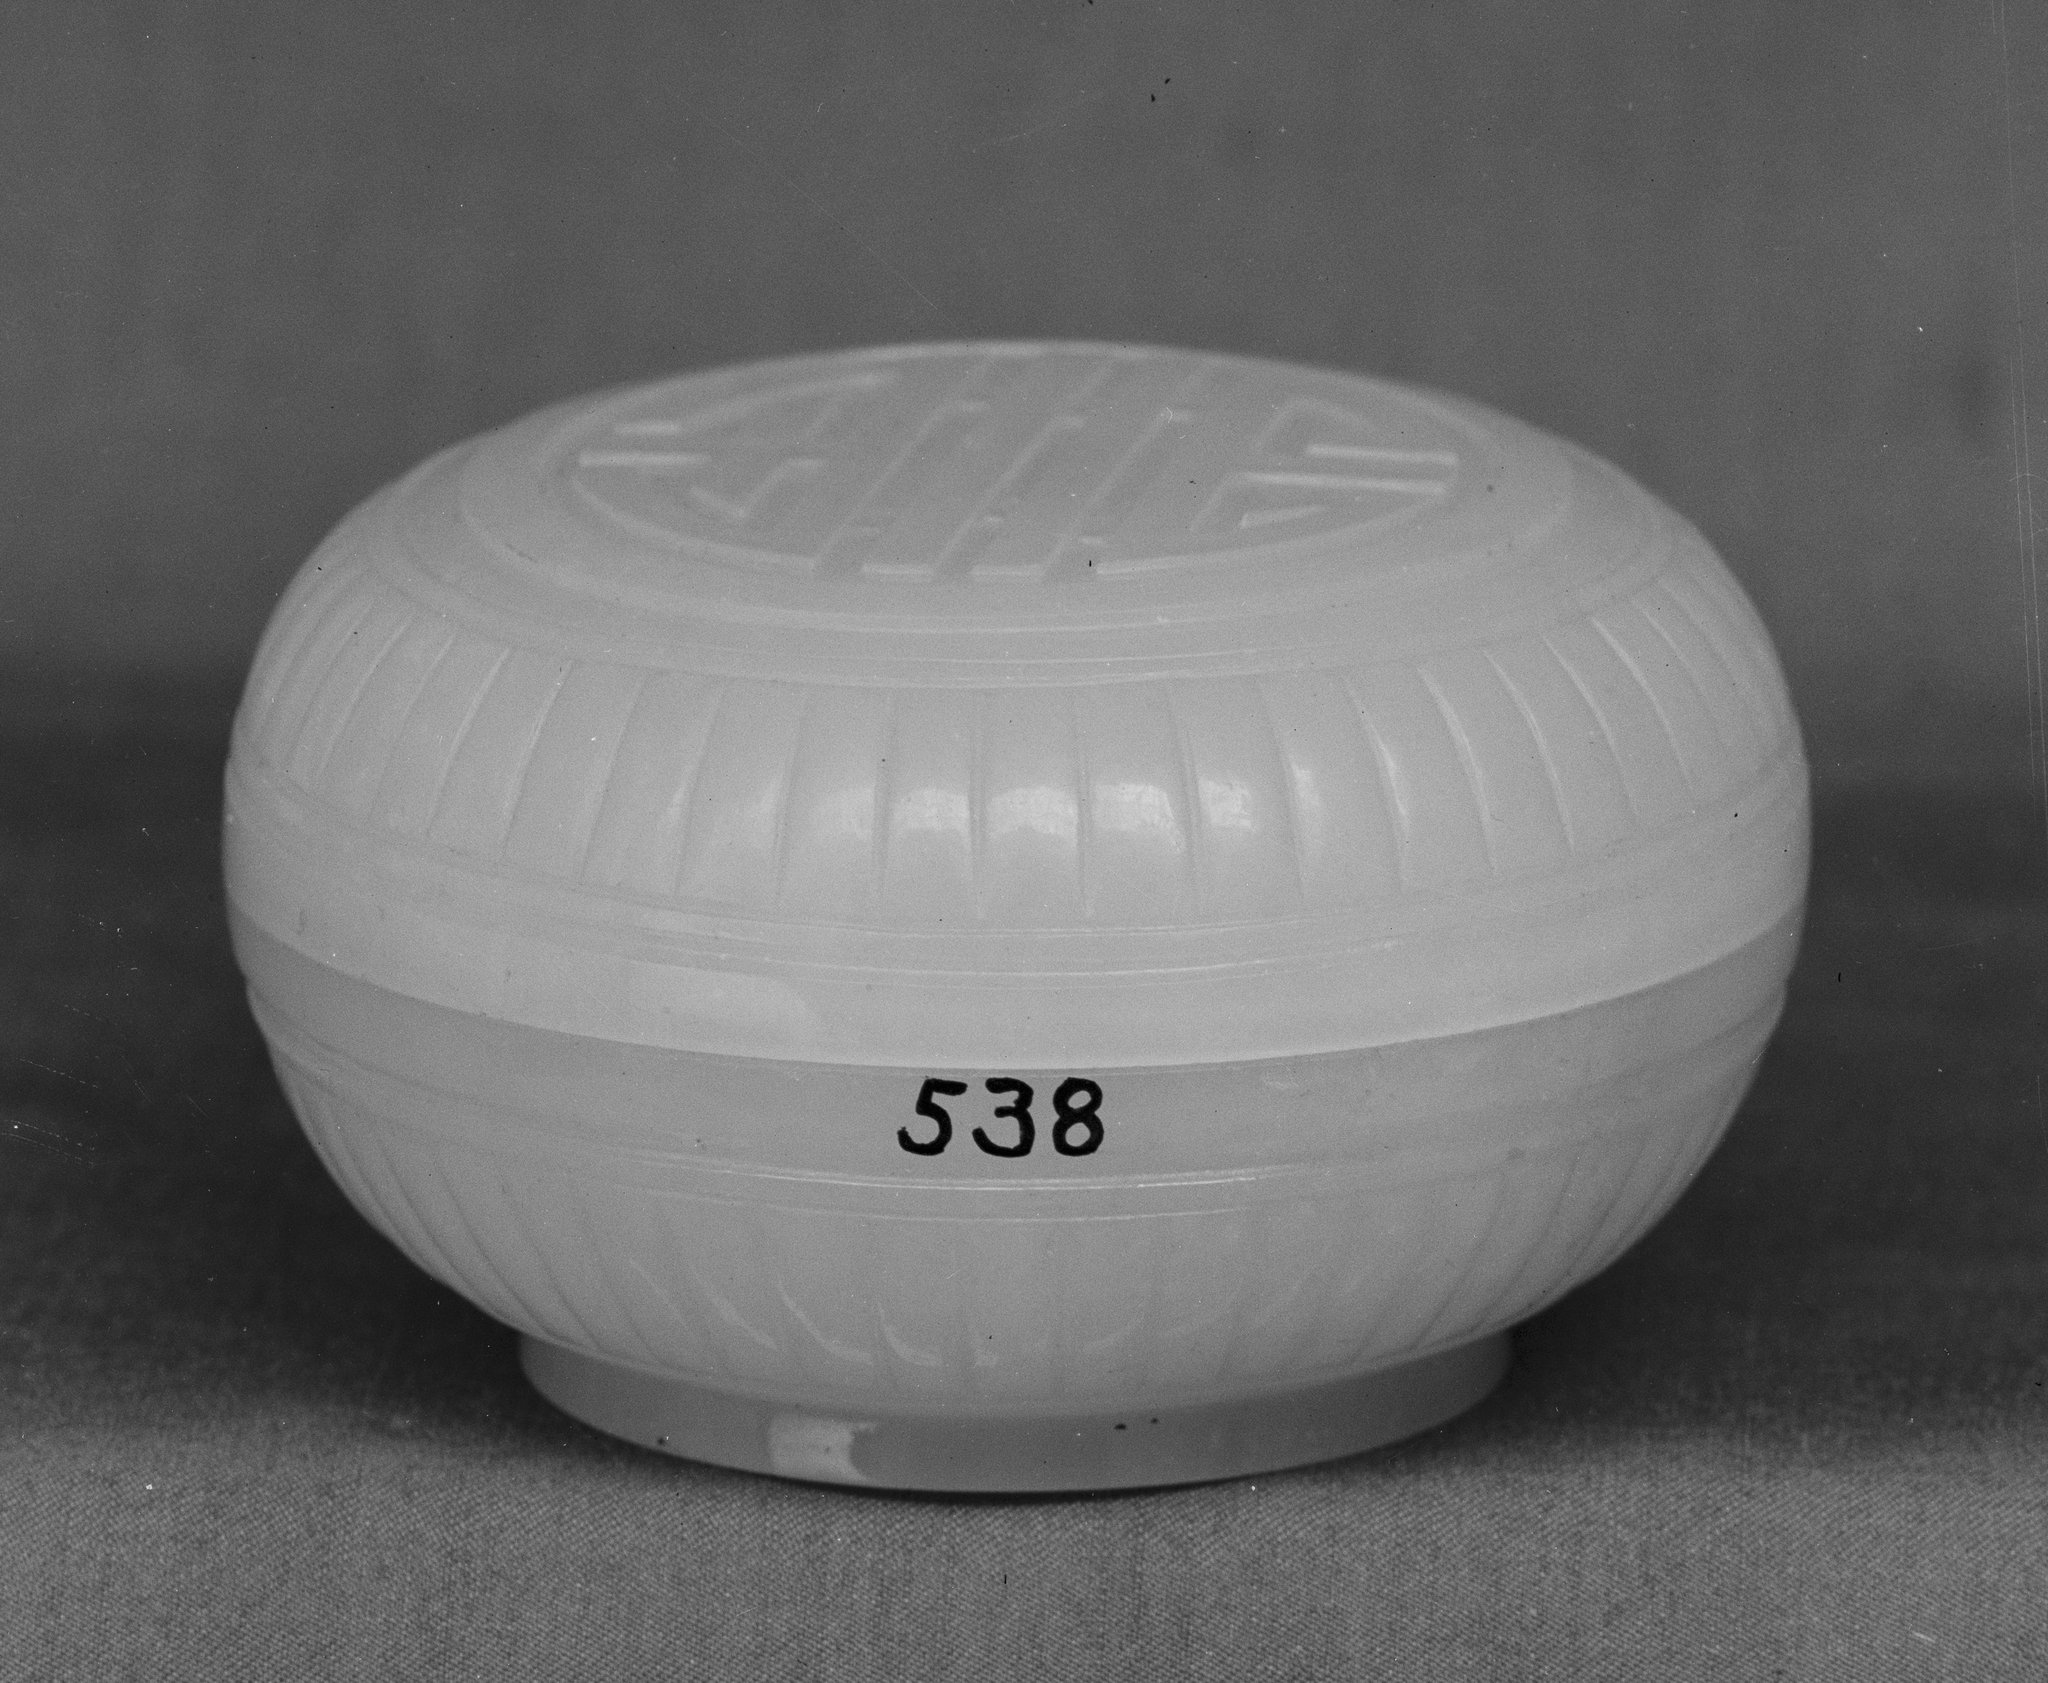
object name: covered box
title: Covered box from an incense set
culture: chinese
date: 1701-1800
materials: jade